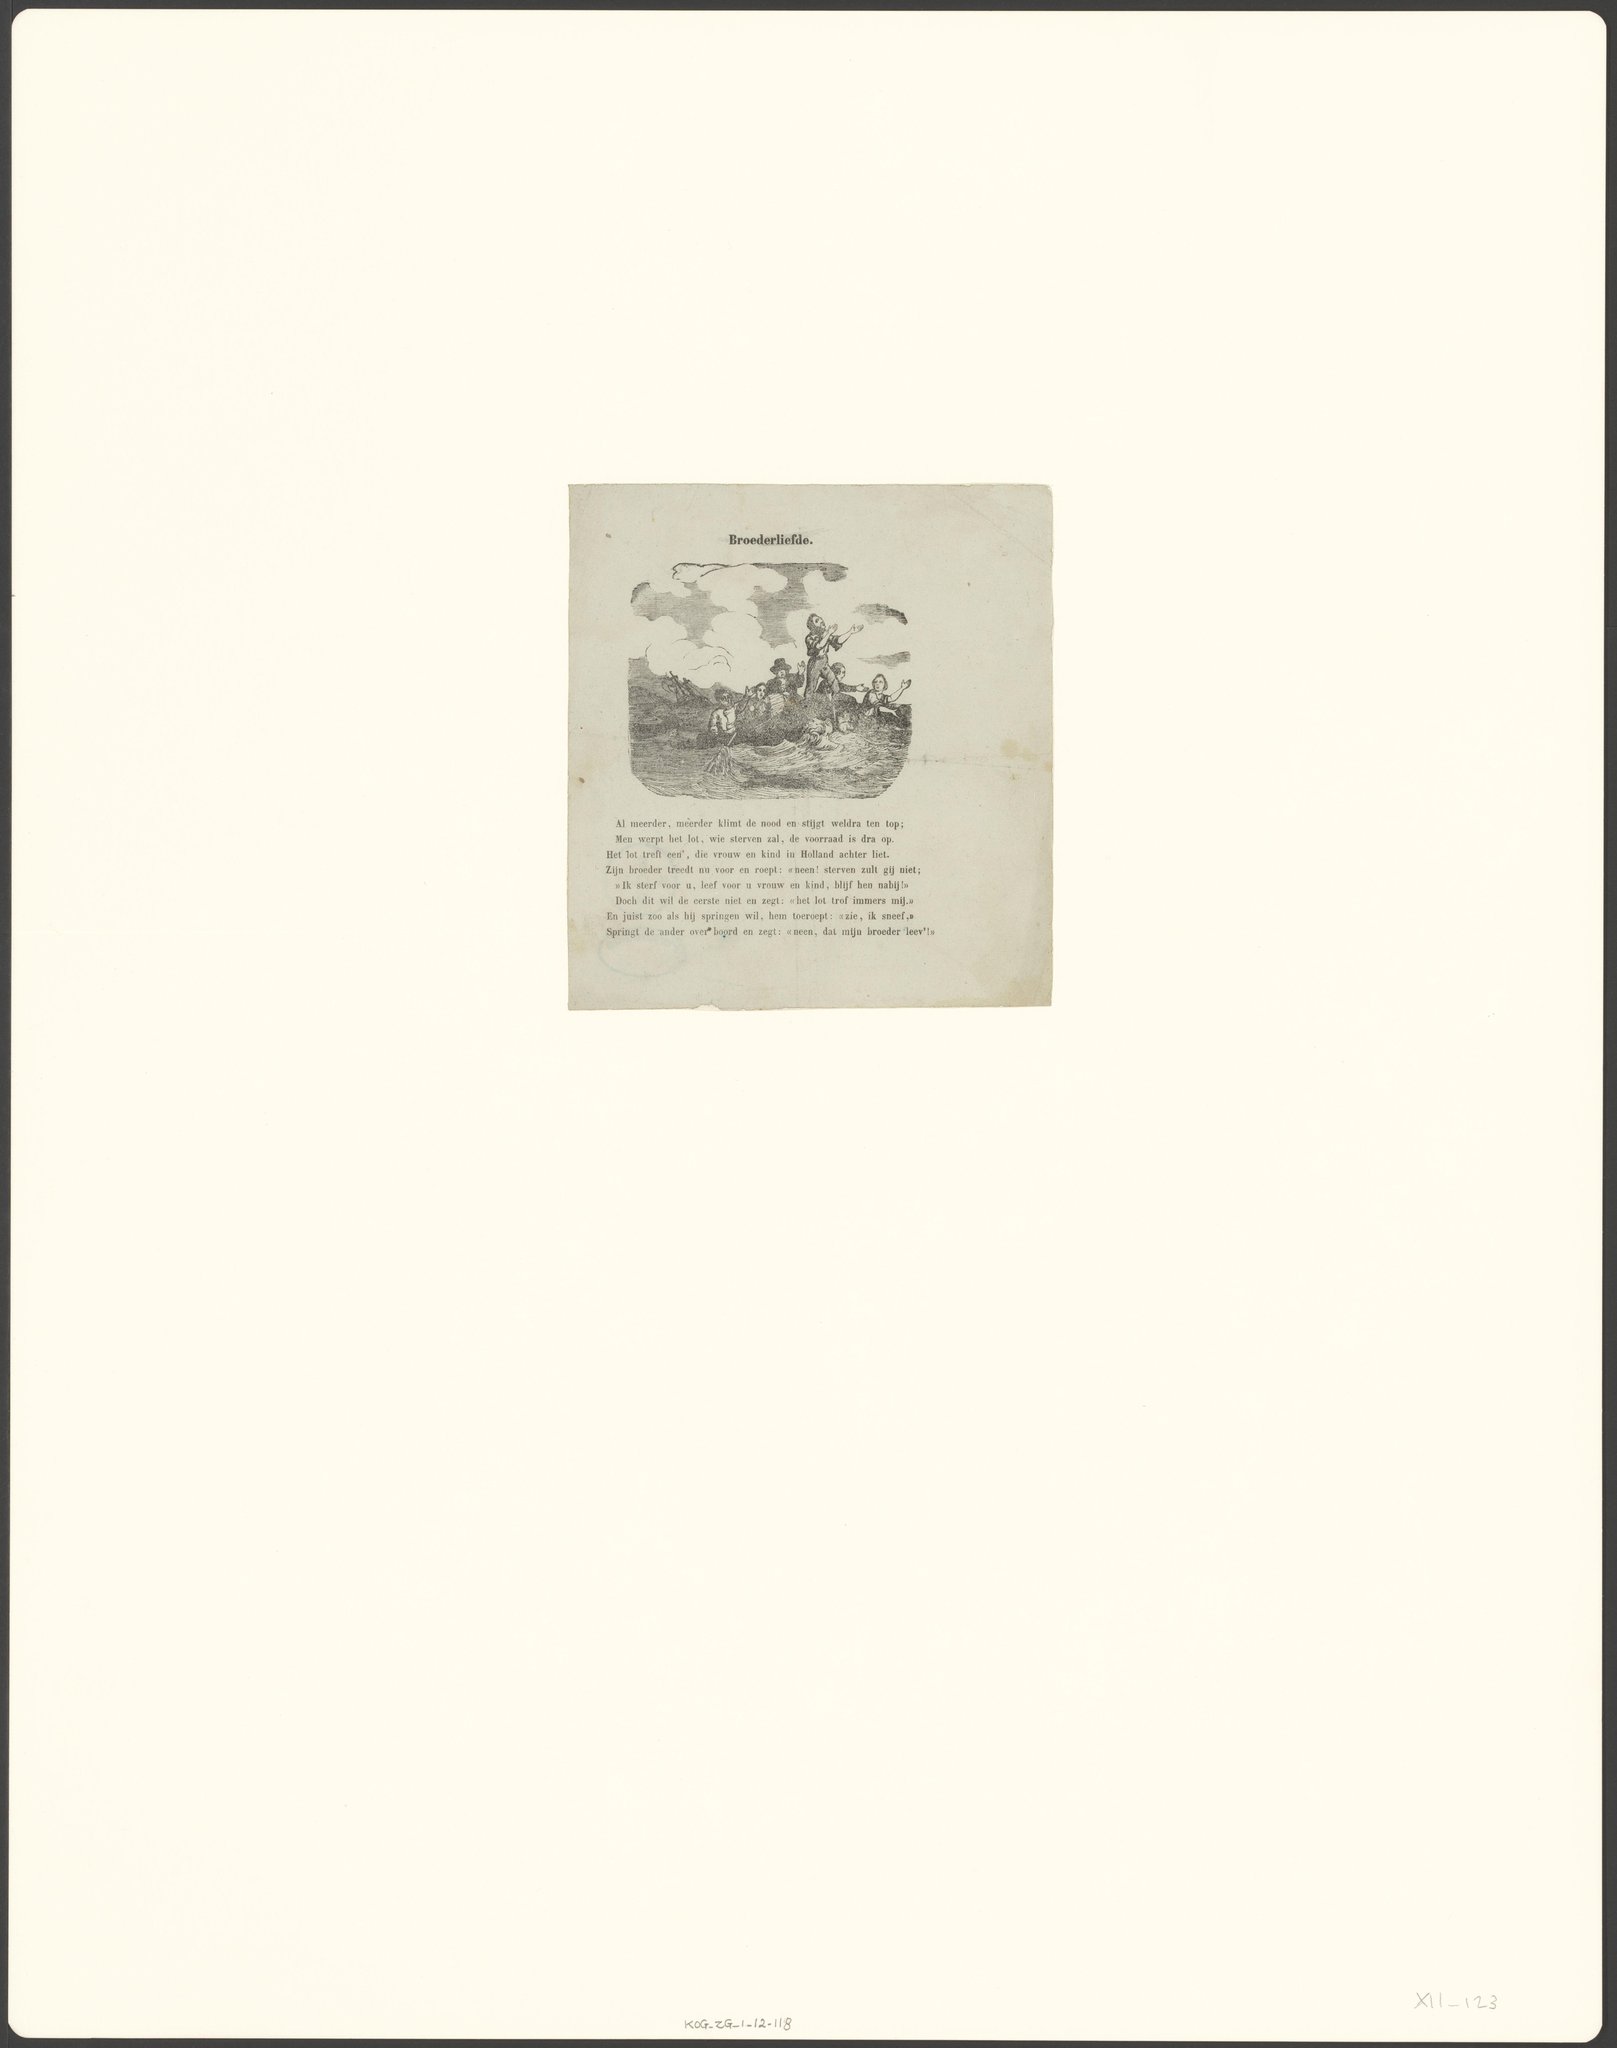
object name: print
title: Man offert zich op voor zijn broer op zee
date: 1844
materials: paper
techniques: engraving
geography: purmerend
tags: shipping accident; sickness and death at sea, sea-burial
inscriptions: stamp, collector's mark: Lugt 1641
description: Onder de afbeelding een achtregelig vers. Onderwerpsrubrieken binnen de Atlas Zeden en Gewoonten: Handel, Nijverheid en Verkeer, Scheepsvaart.